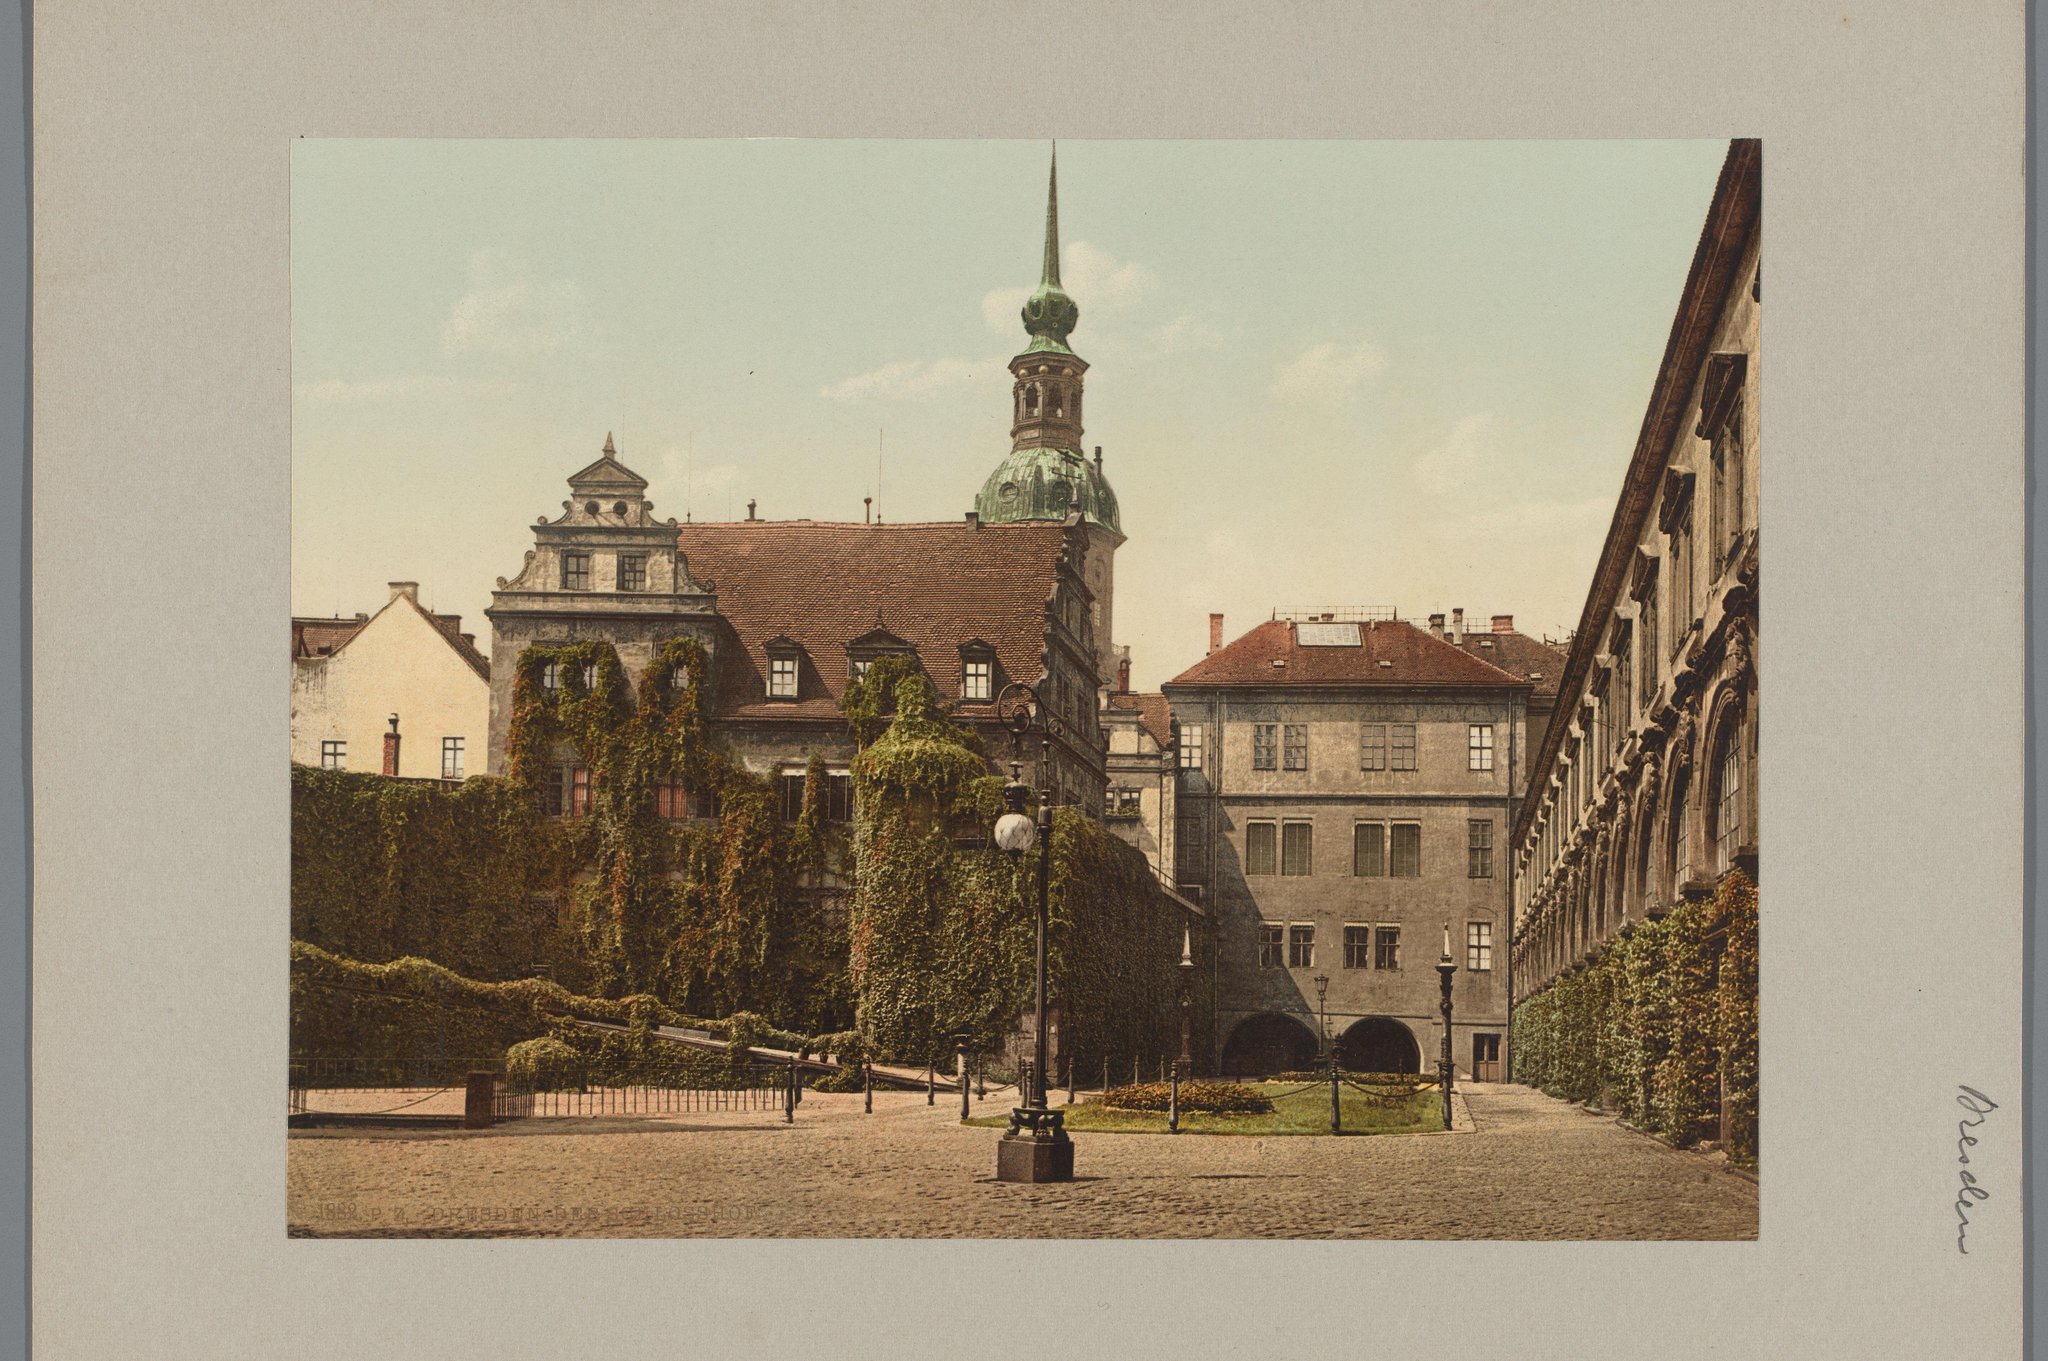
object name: photograph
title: Dresden Der Schlosshof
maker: Anonymous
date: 1880-1920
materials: cardboard, photographic process, photographic support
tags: dresden